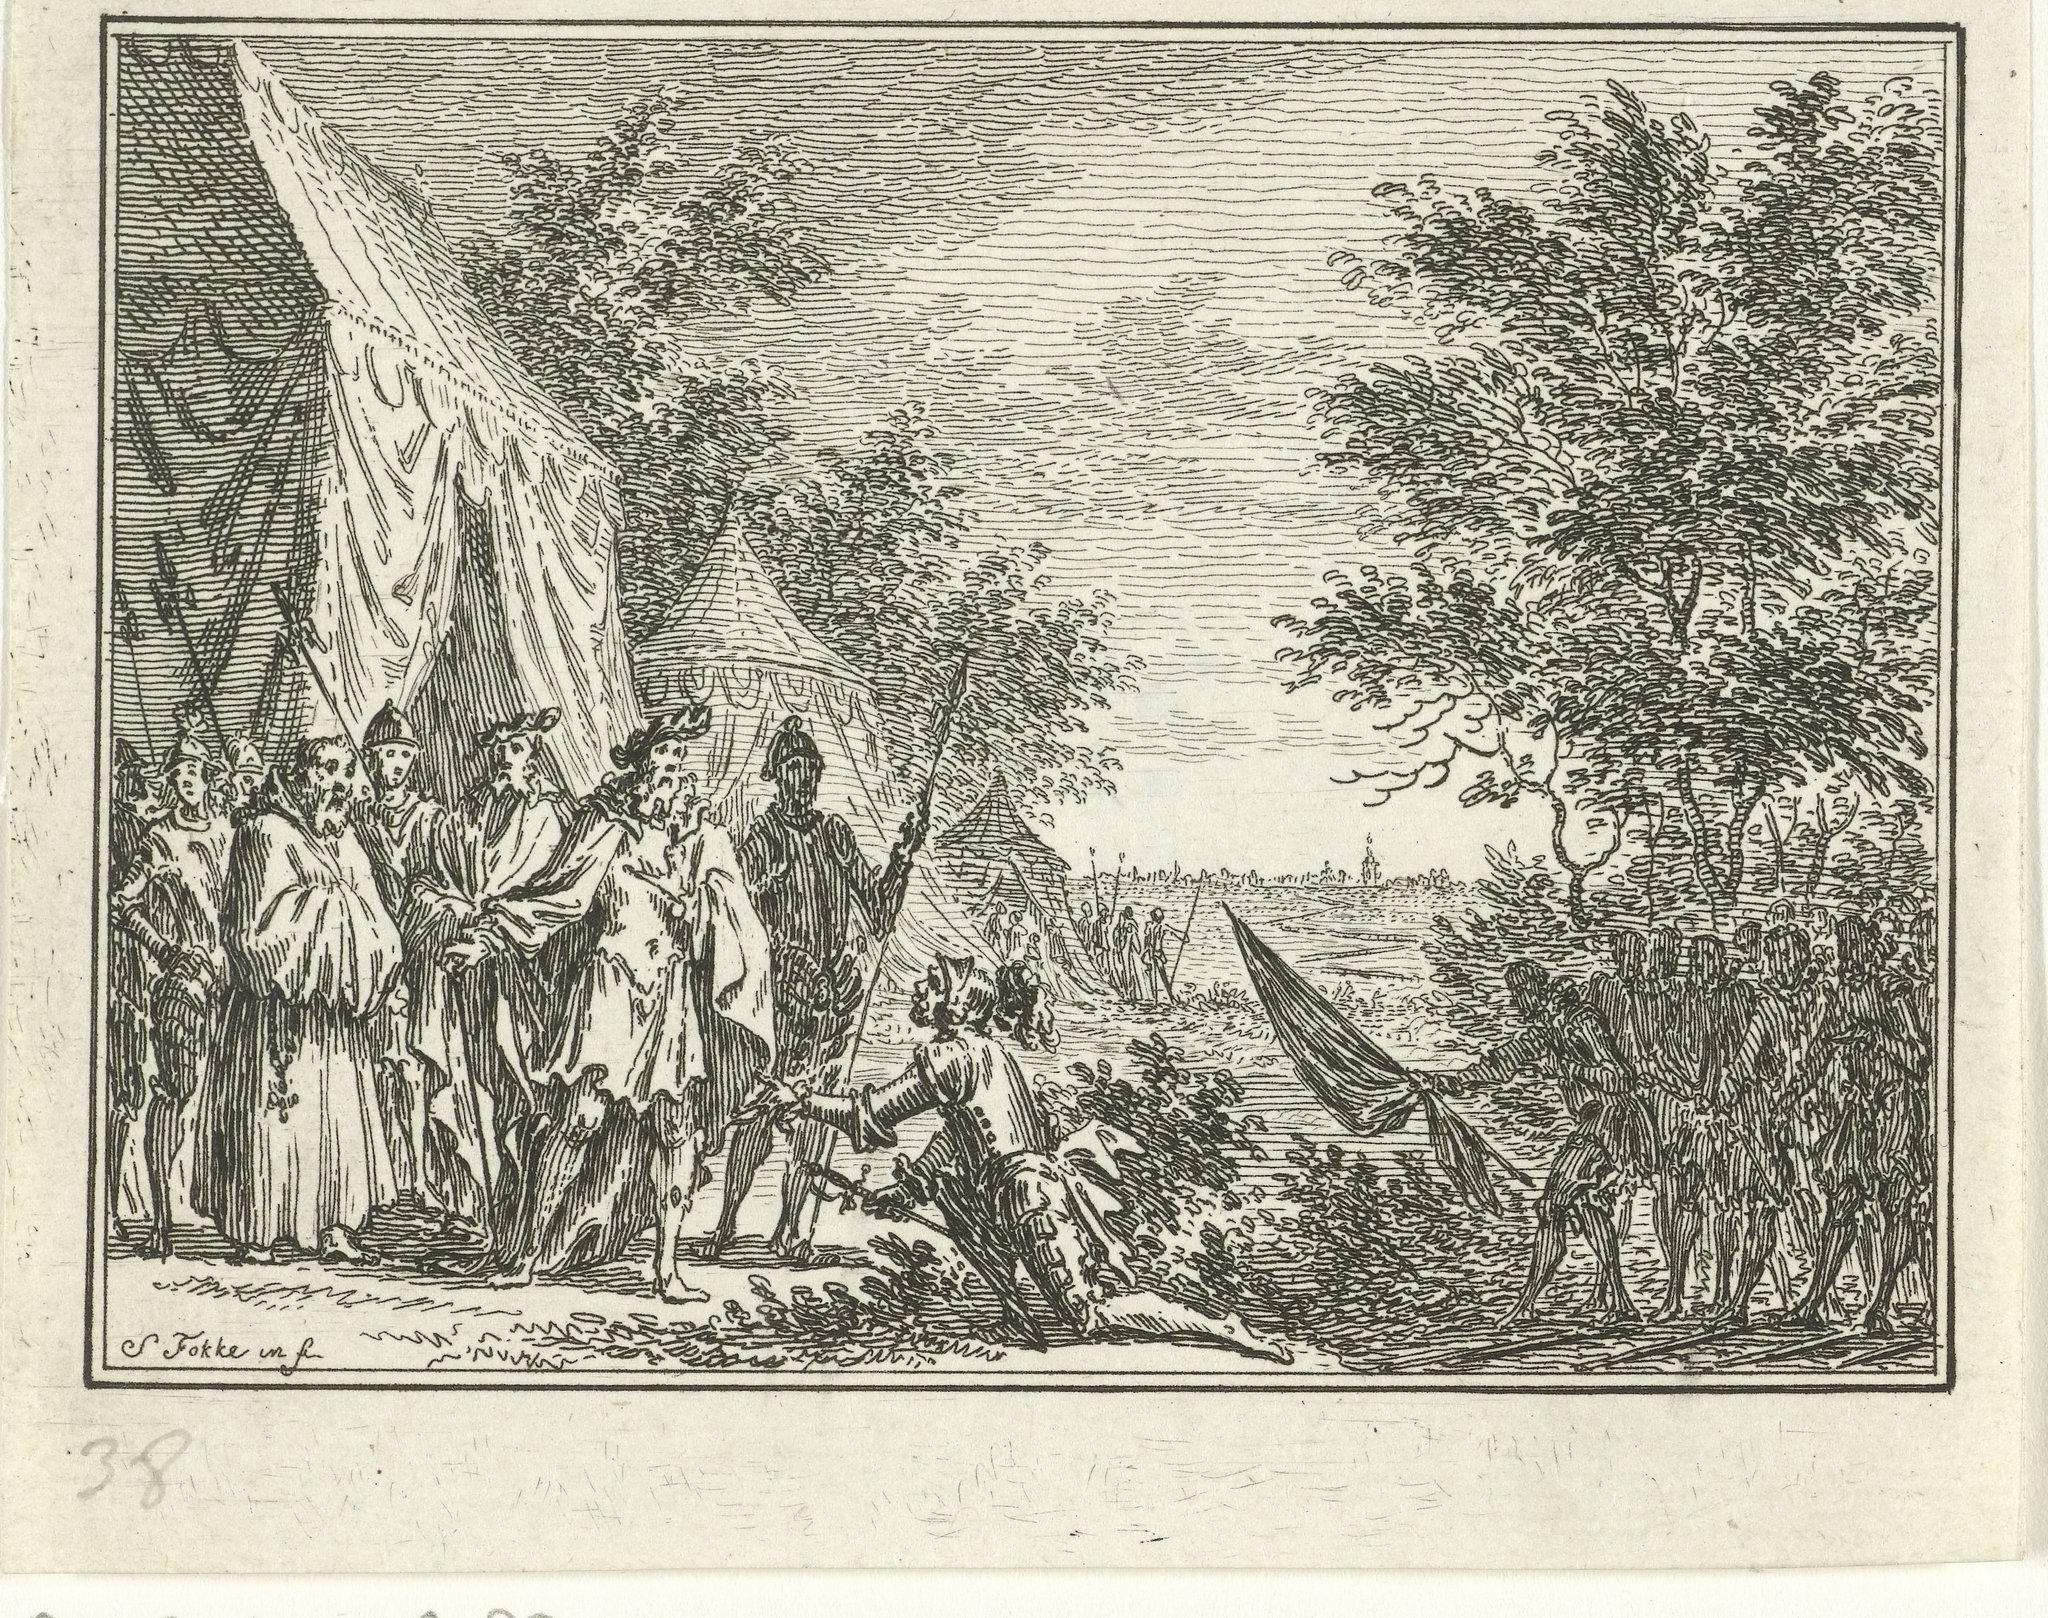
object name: print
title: Overgave bij een tentenkamp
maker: simon fokke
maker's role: draughtsman, print maker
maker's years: 1712-1784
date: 1722-1784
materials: paper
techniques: etching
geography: amsterdam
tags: surrender ~ war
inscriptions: collector's mark: Lugt 2228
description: Voorstellingen uit de vaderlandse geschiedenis. Een soldaat in harnas knielt voor een groep mannen bij een tentenkamp en overhandigt hun het zwaard. Achter de geknielde soldaat houdt een figuur een vlag voor zich uit.